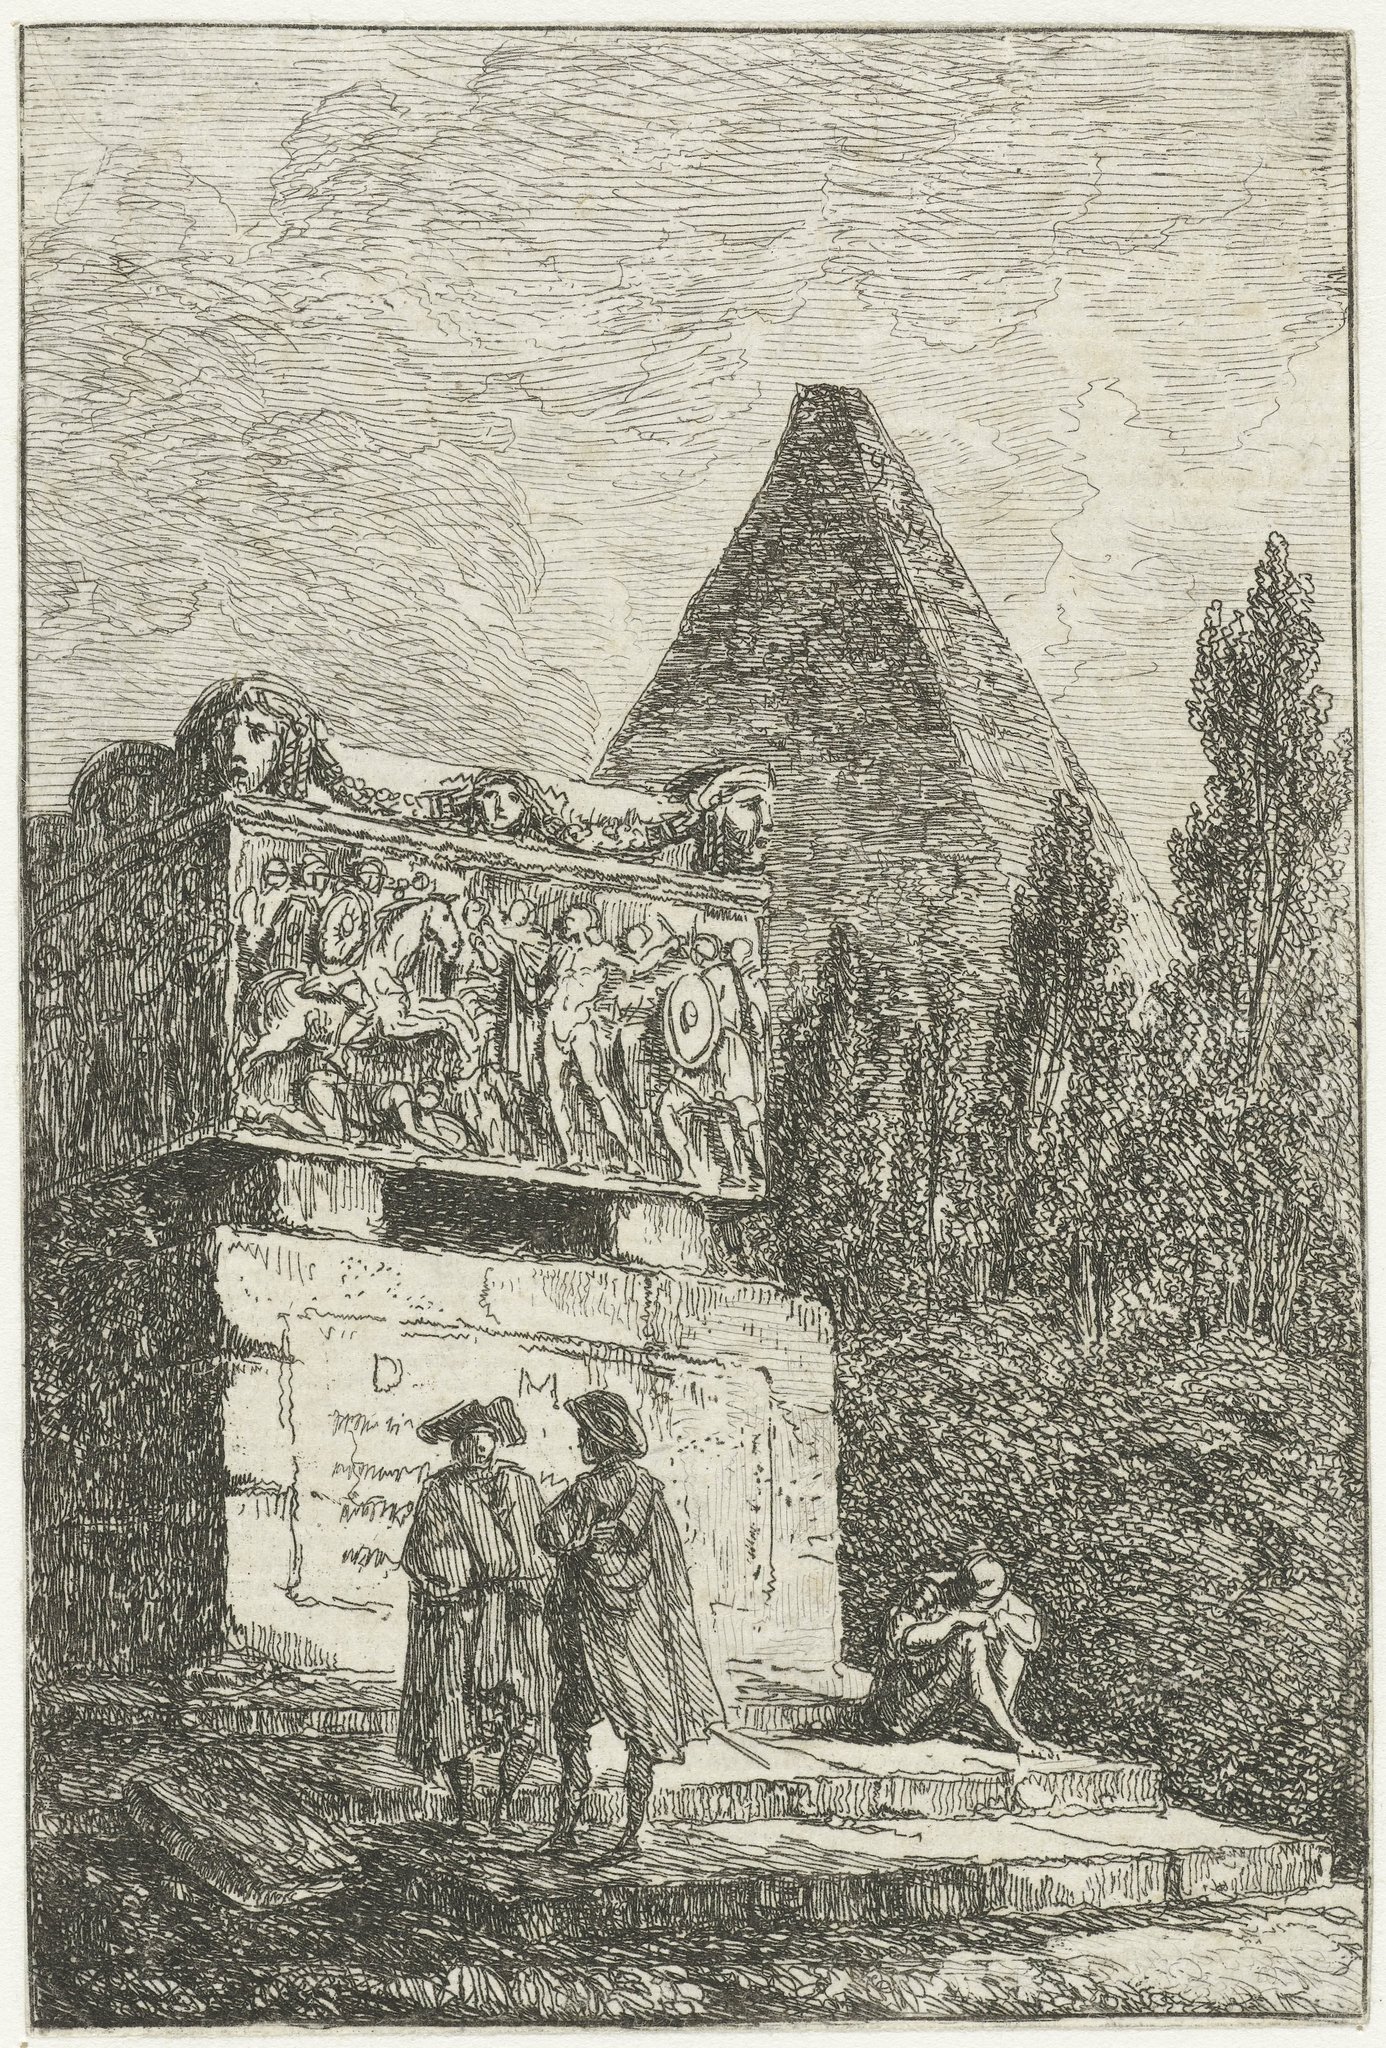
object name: print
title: Romeinse gezichten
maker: hubert robert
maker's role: draughtsman, print maker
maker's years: 1733-1808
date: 1763-1766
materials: paper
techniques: etching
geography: rome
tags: landscape with ruins, sarcophagus, pyramid (historical grave form)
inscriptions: collector's mark: Lugt 2228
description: Drie figuren bij een antieke sarcofaag in een landschap. Op de achtergrond een piramide achter een aantal cipressen. Zesde prent uit een serie van tien.